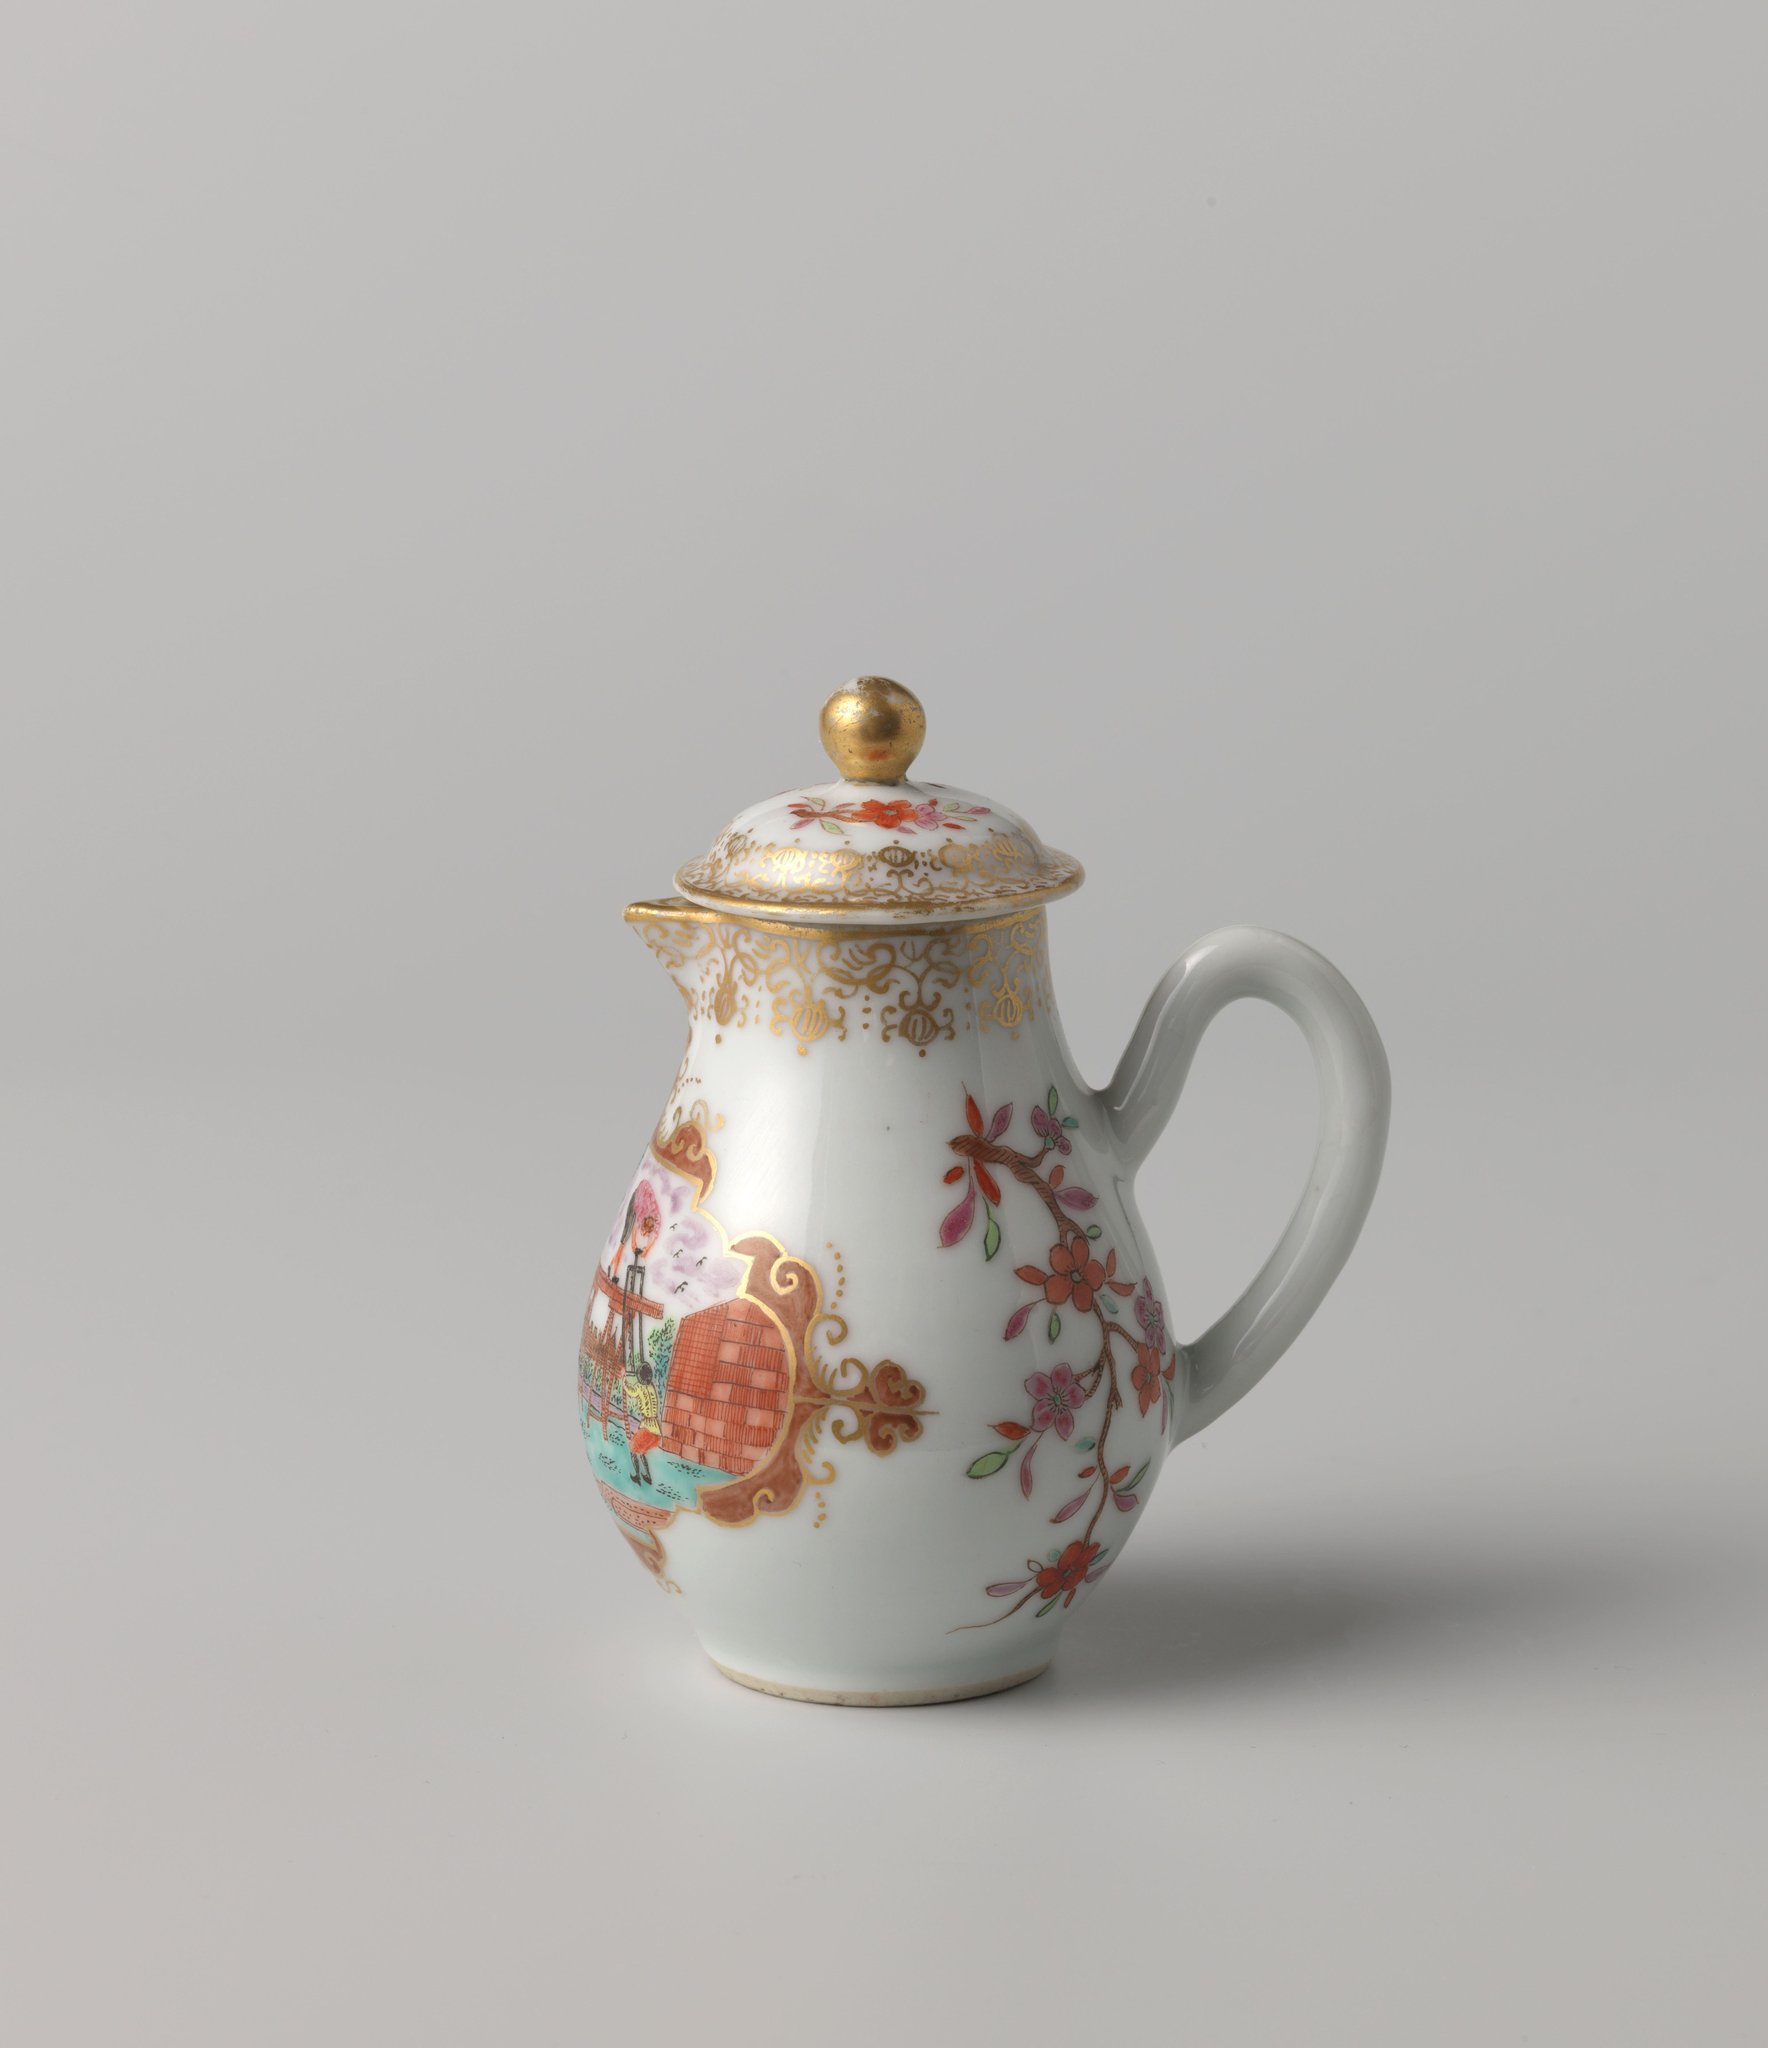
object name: milk jug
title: Pear-shaped milk jug with Europeans in a landscape and two flower sprays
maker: Anonymous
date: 1775-1799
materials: glaze, gold, paint, porcelain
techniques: firing, gilding, turning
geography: china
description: Deksel van peervormige melkkan van porselein, beschilderd op het glazuur in blauw, rood, roze, groen, geel, zwart en goud. Beschilderd met een band met ranken en twee bloemtakken. Europese vorm en voorstelling in emailkleuren.